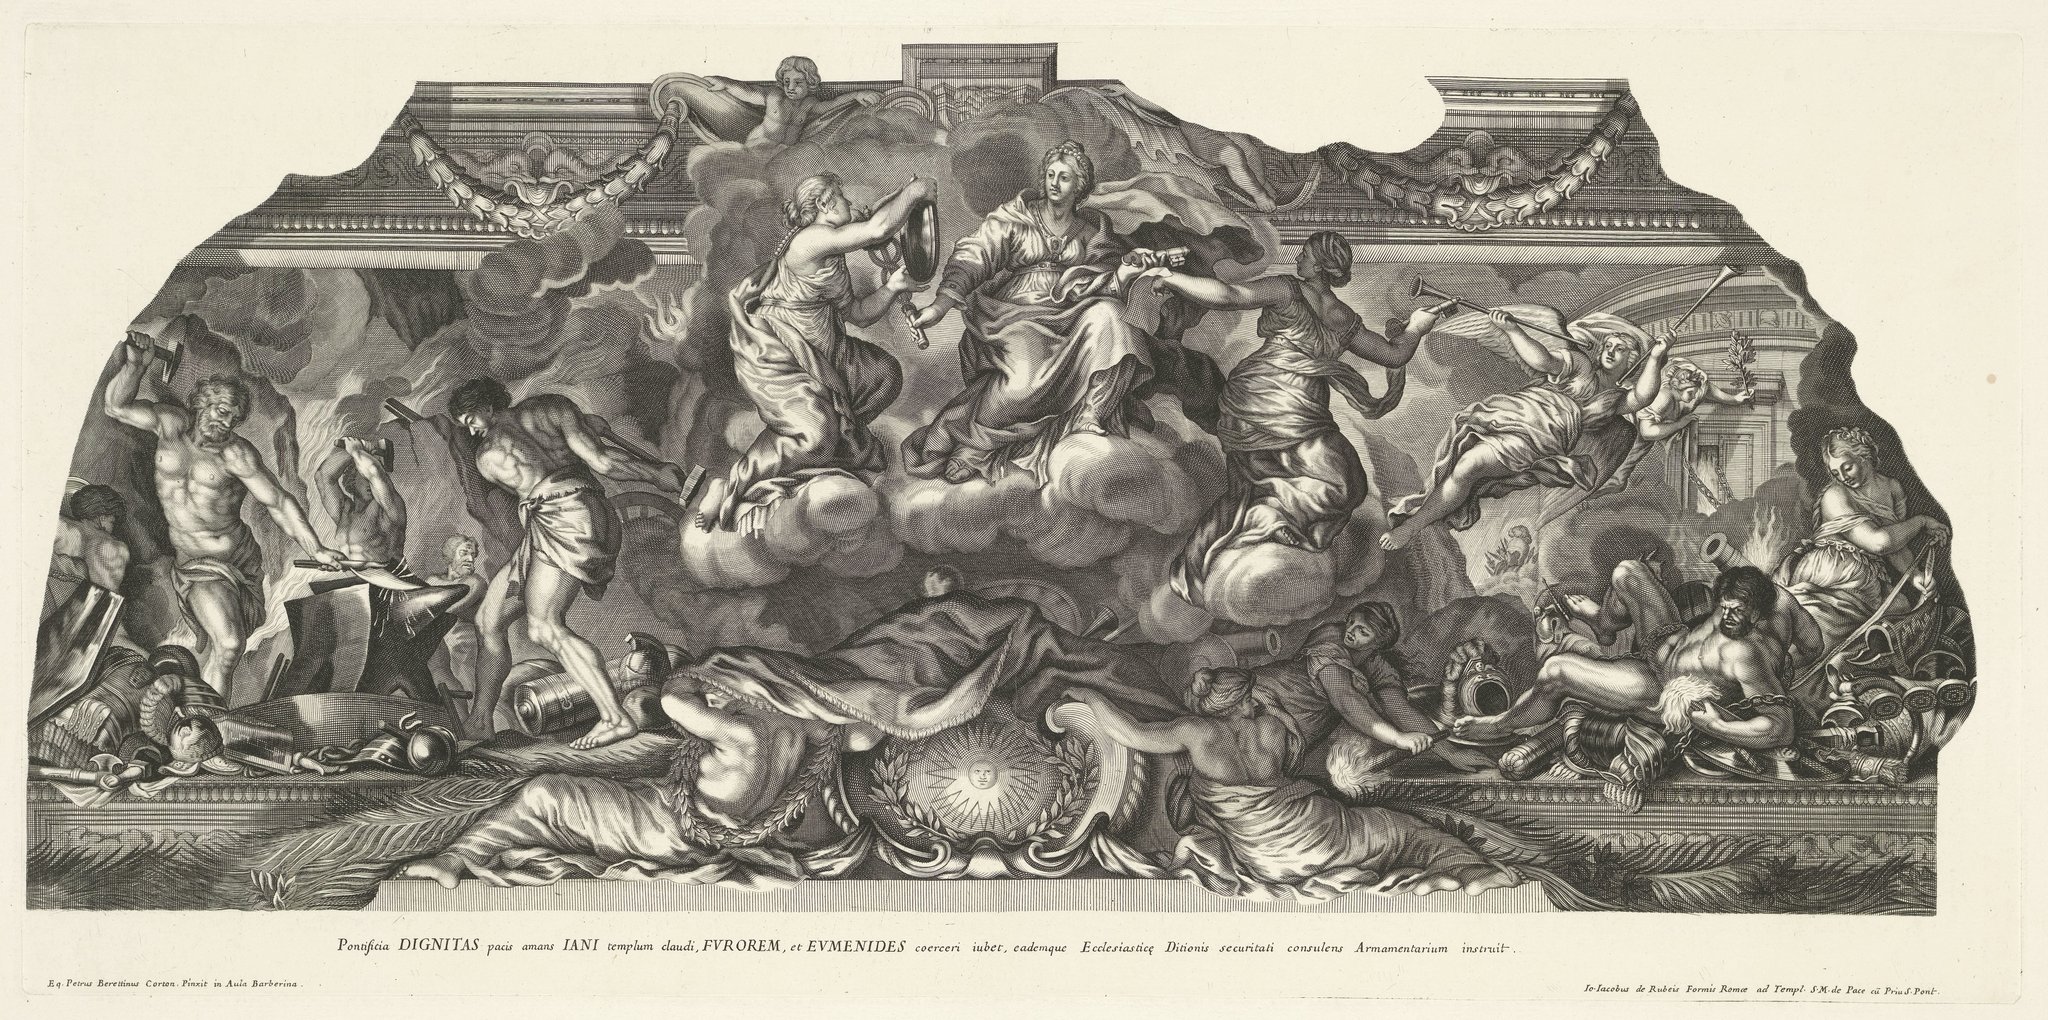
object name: print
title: Barberinae Aulae Fornix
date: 1692-1762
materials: paper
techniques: engraving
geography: vatican city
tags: (story of) vulcan (hephaestus), (story of) cyclopes as fellow blacksmiths of vulcan, in the god's forge, honour, glory; 'ampiezza della gloria', 'gloria', 'gloria de prencipi', 'gloria & honore', 'honore', 'sublimatà della gloria' (ripa), prudentia (prudence) as roman personification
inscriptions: collector's mark: Lugt 240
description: Deel van de gewelfdecoratie in de salon van Palazzo Barberini met Autorità Pontifica geflankeerd door Voorzichtigheid en Glorie. Links Vulcanus en de cycloop. Tekst in het Latijn in ondermarge.